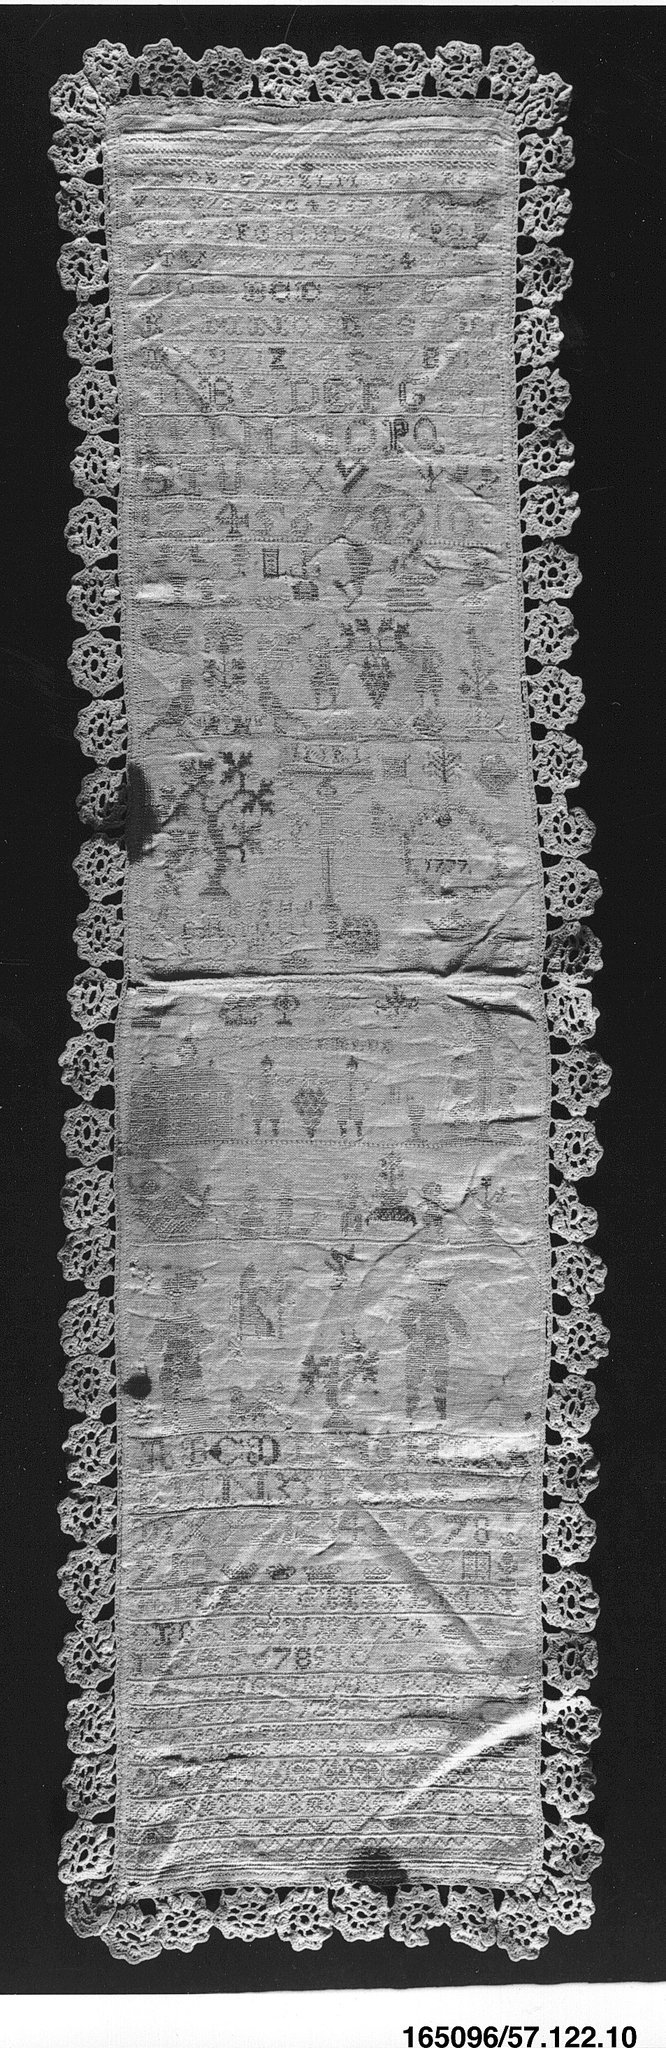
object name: sampler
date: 1777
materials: linen, silk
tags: human figures,birds,trees